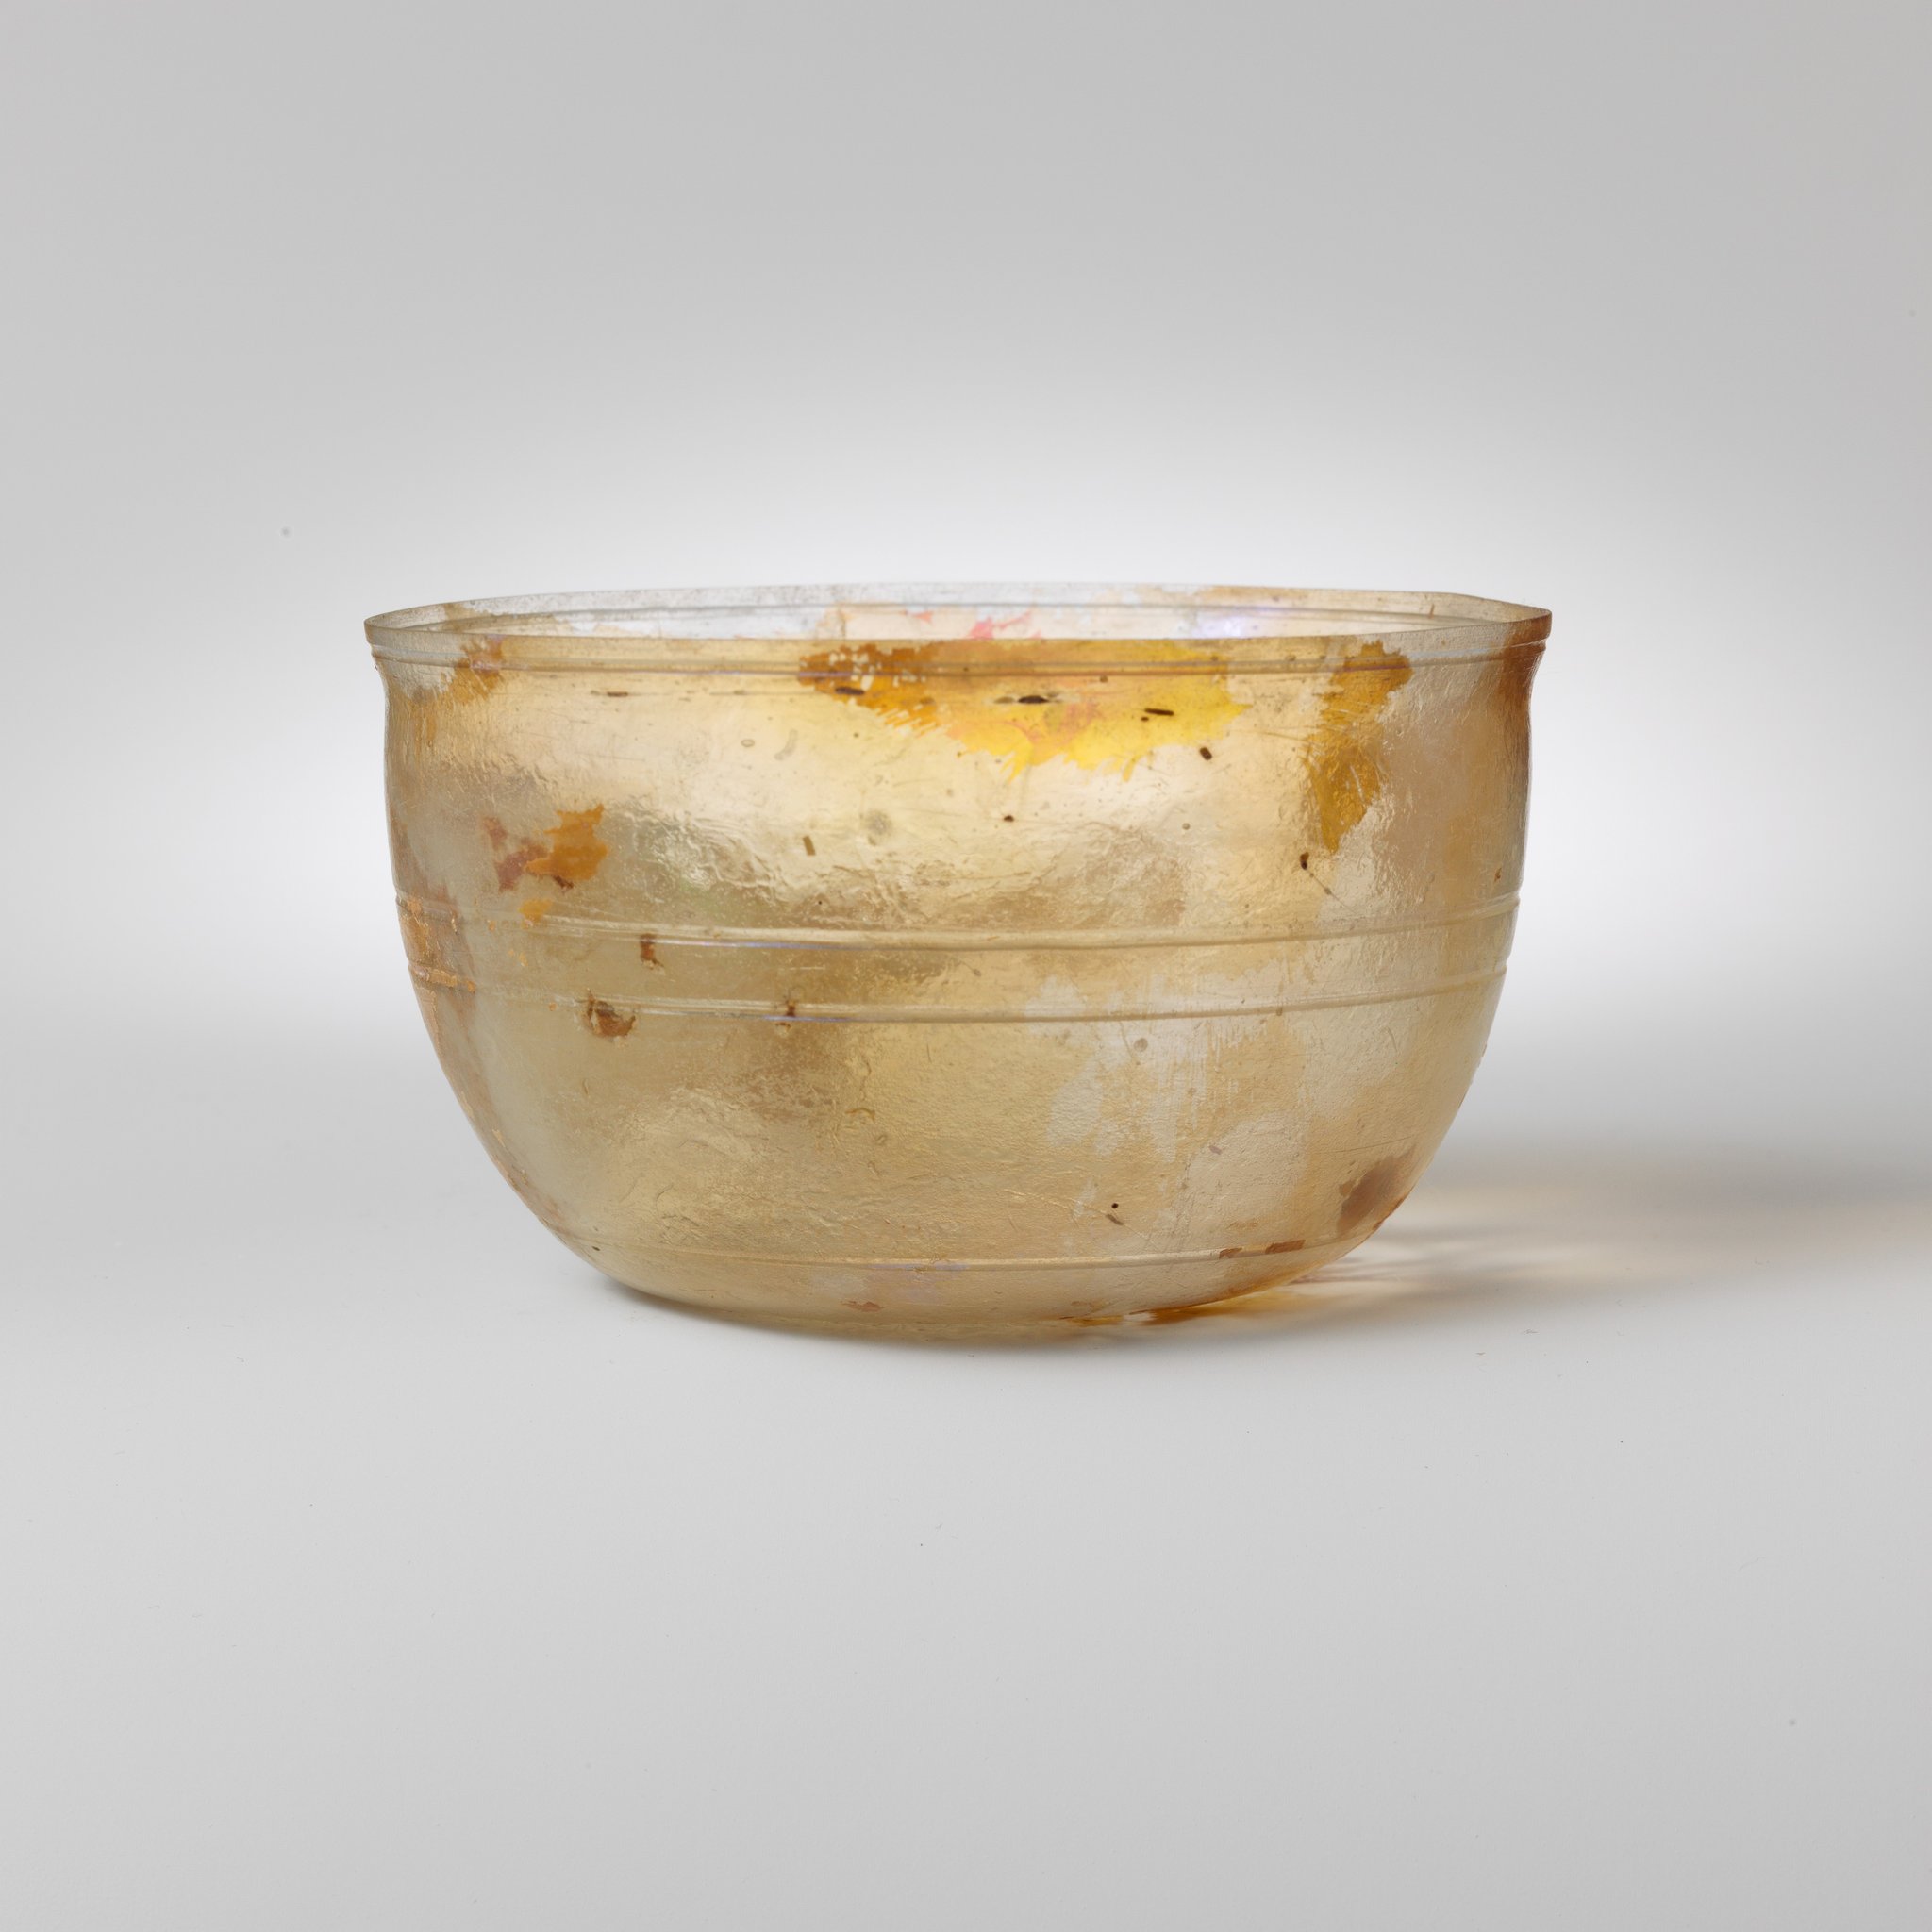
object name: bowl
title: Glass bowl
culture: roman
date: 34-200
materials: glass